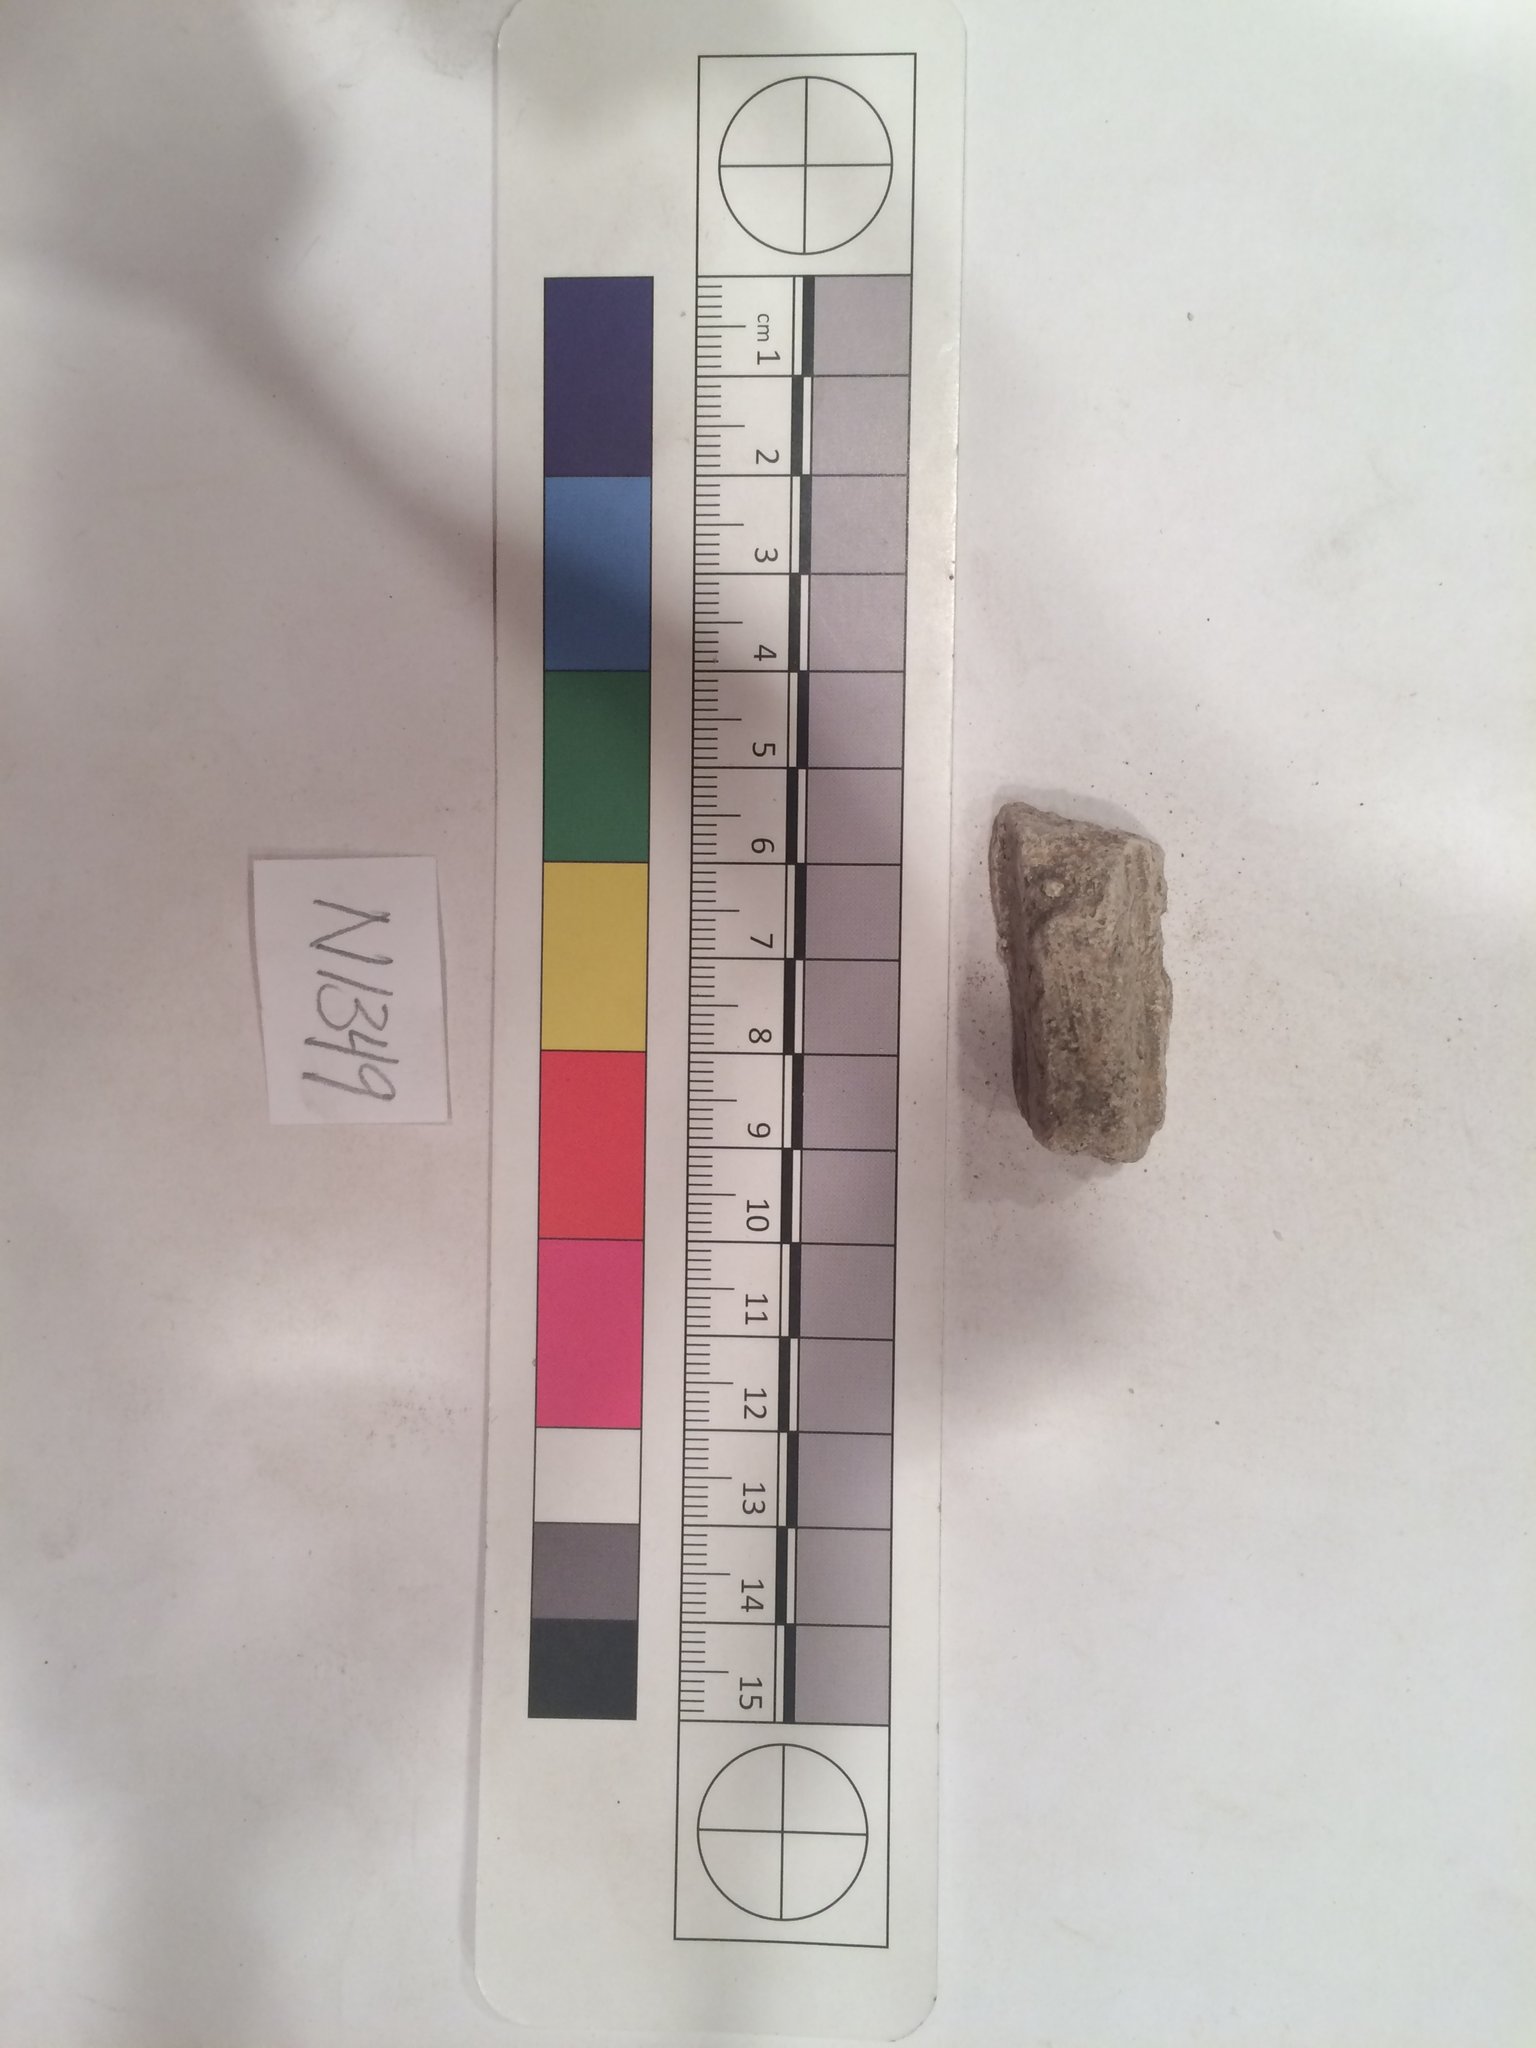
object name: fragment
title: Stucco Fragment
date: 701-1200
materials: plaster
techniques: carving, painting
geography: iran